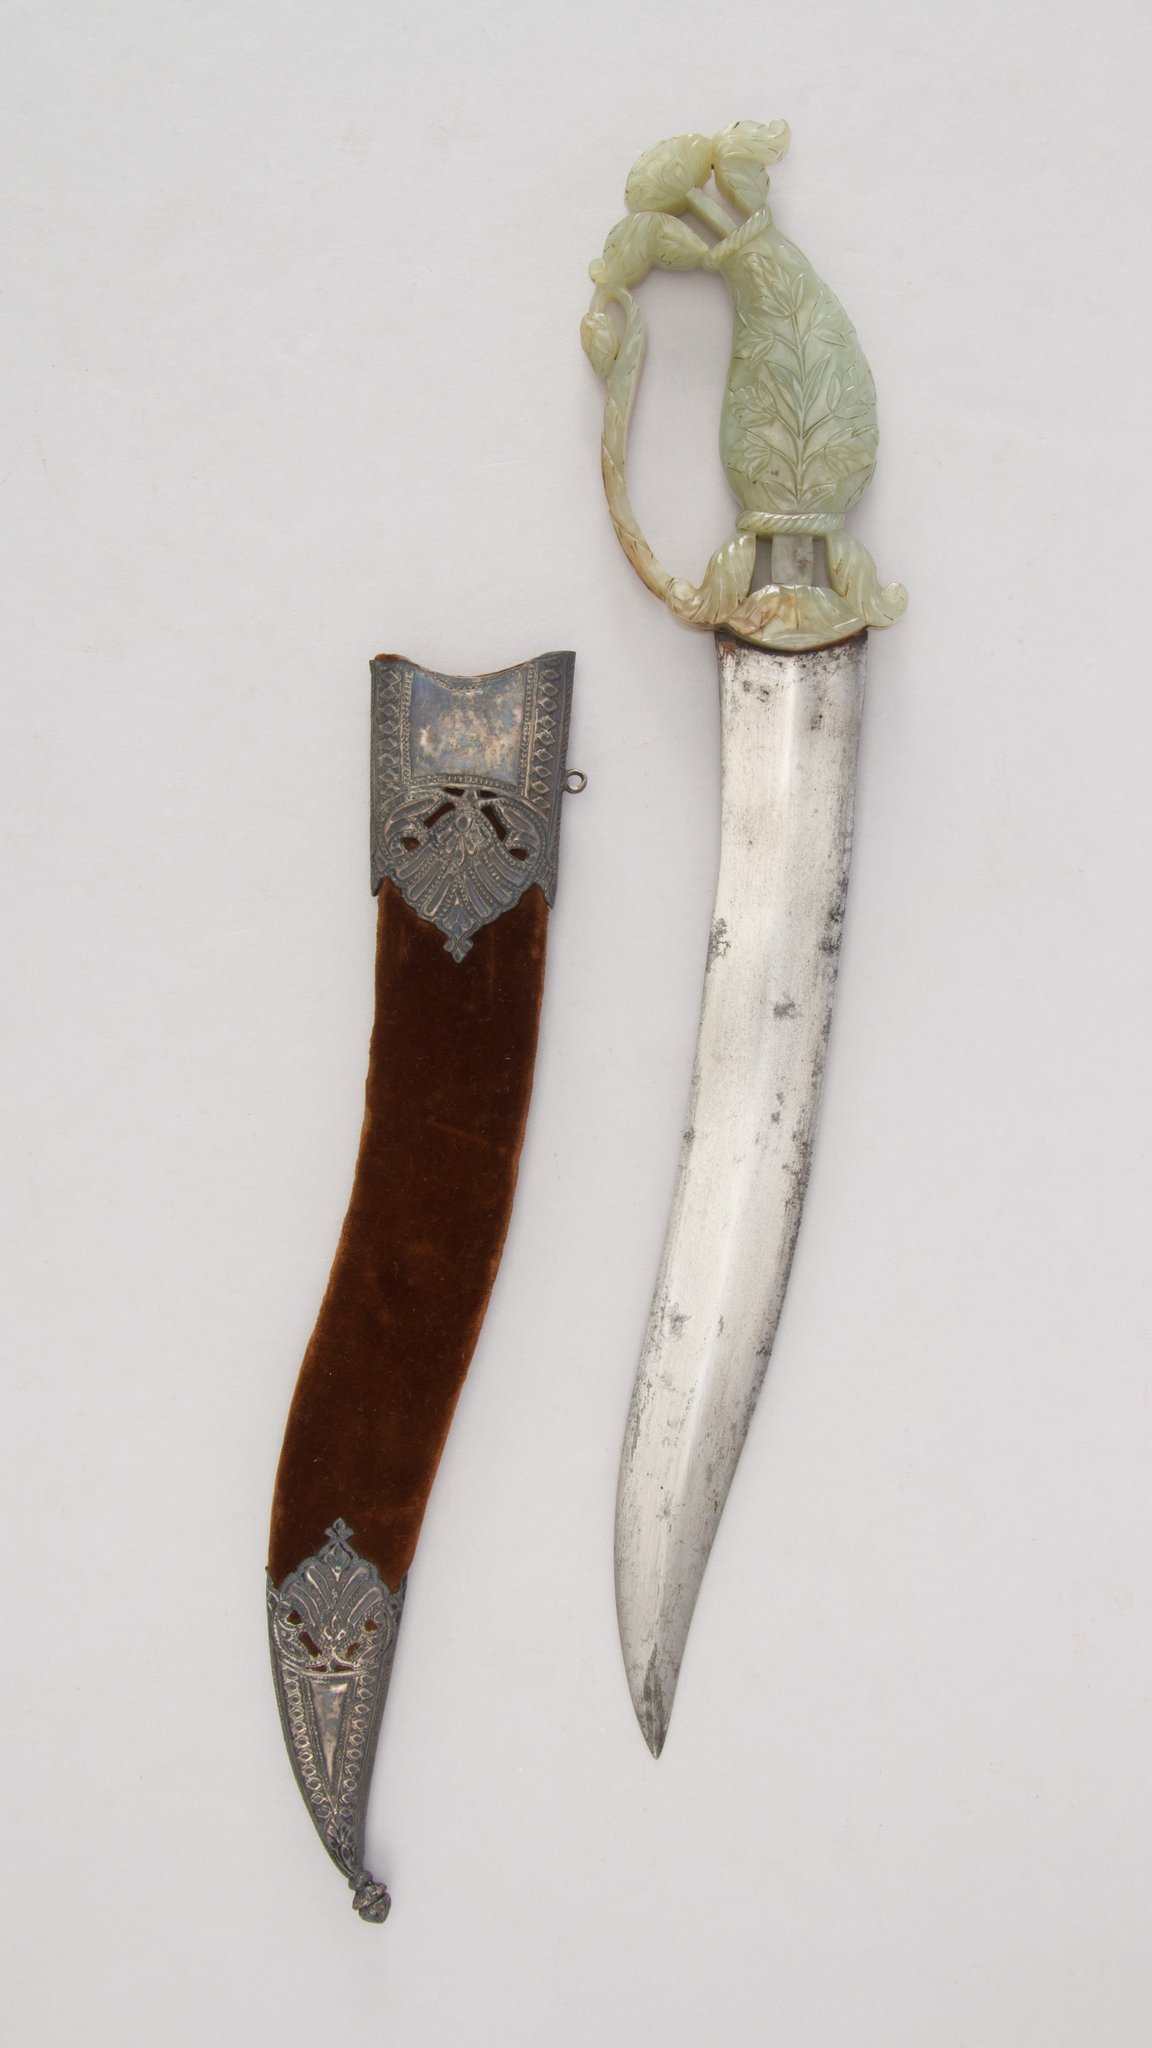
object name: dagger jambiya with sheath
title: Dagger (Jambiya) with Sheath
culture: indian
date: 1701-1900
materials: jade, silver, steel, velvet, wood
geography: india